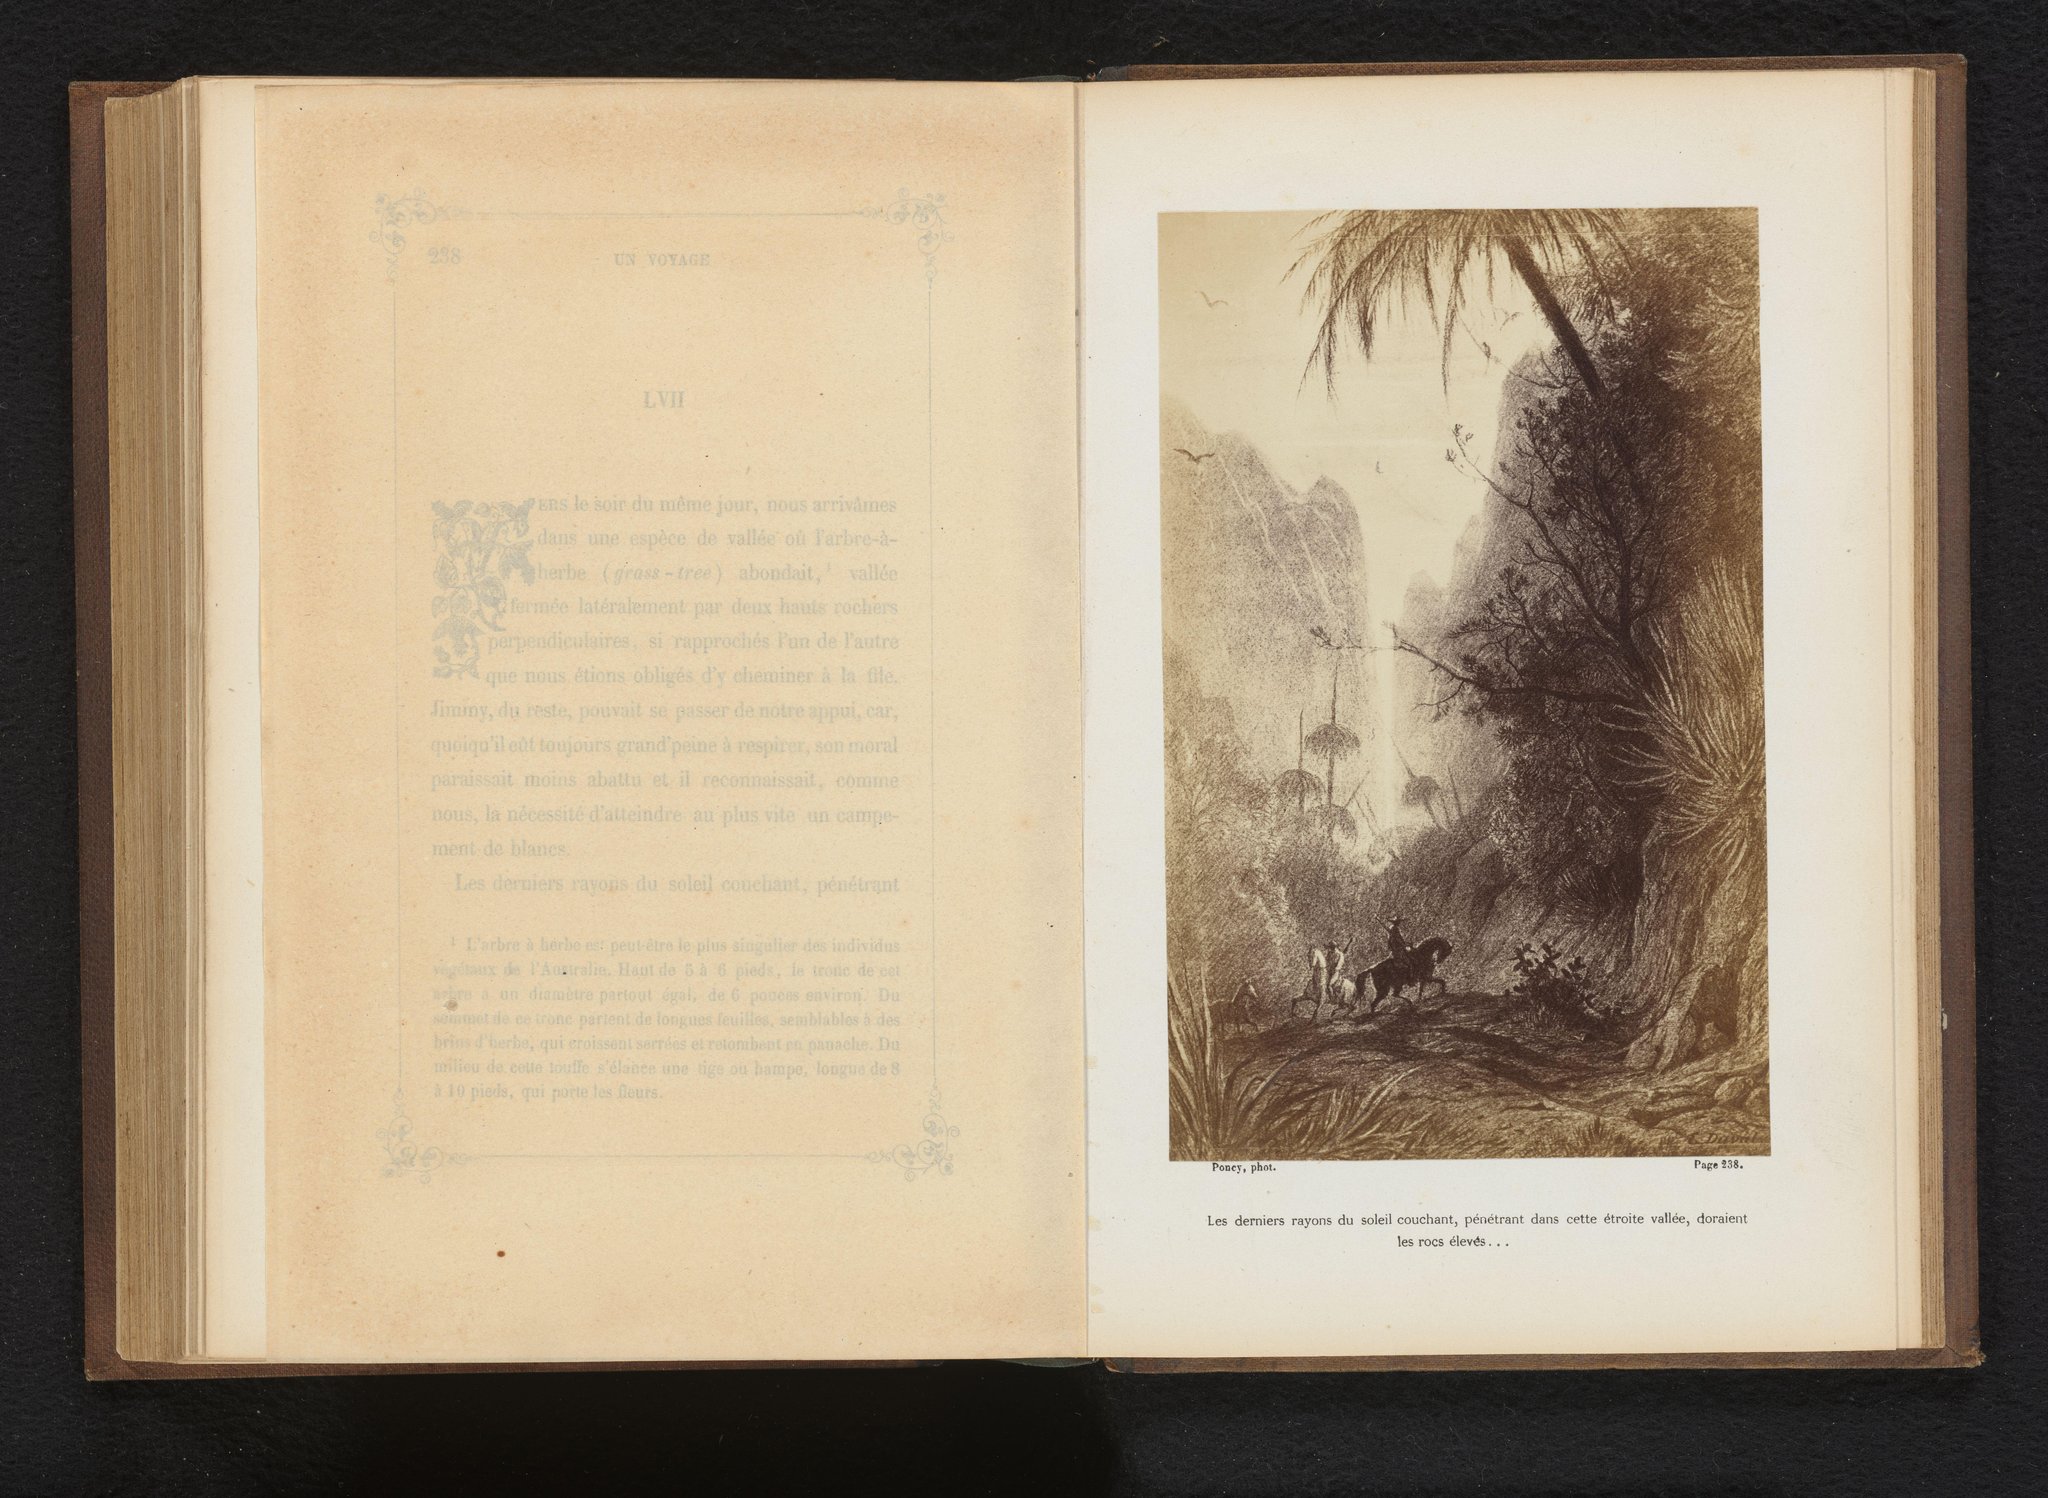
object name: page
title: Les derniers rayons du soleil couchant, pénétrant dans cette étroite vallée, doraient les rocs élevés...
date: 1863-1868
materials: paper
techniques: albumen print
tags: riding a horse, ass, or mule; rider, horseman, dale, valley, dusk, evening twilight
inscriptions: inscription: ‘Page 238.’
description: Foto op ongenummerde pagina na pagina 238.